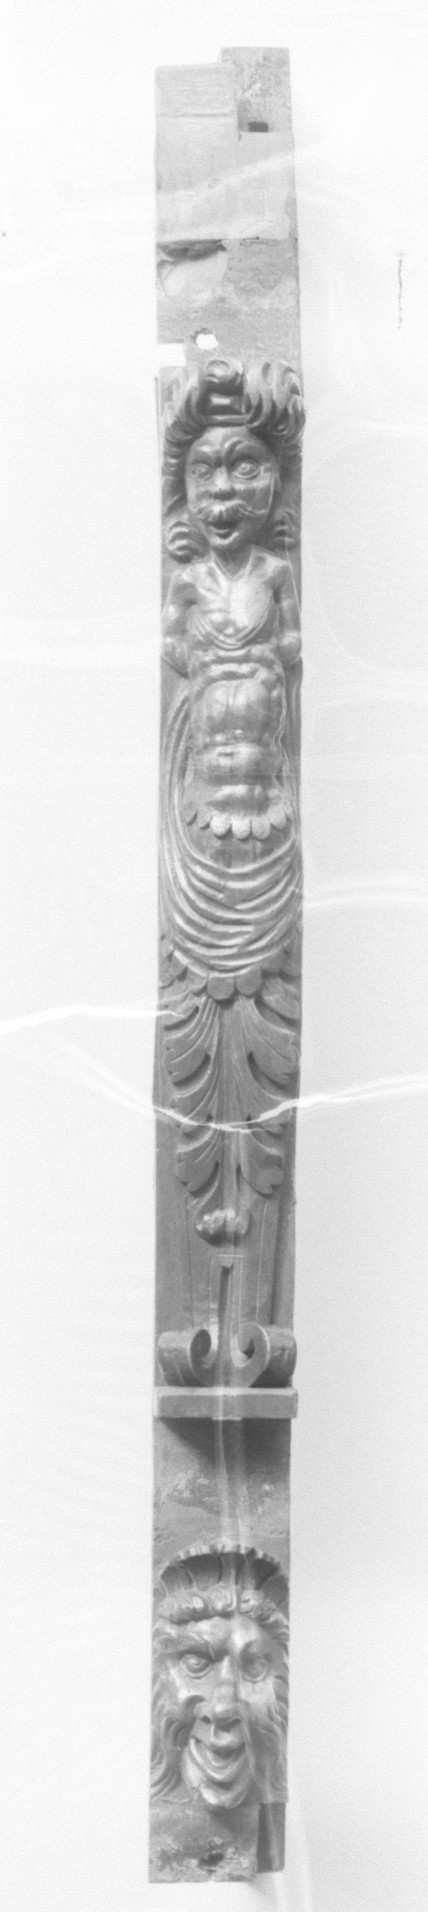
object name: corner post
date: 1501-1600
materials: wood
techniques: carving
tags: human figures